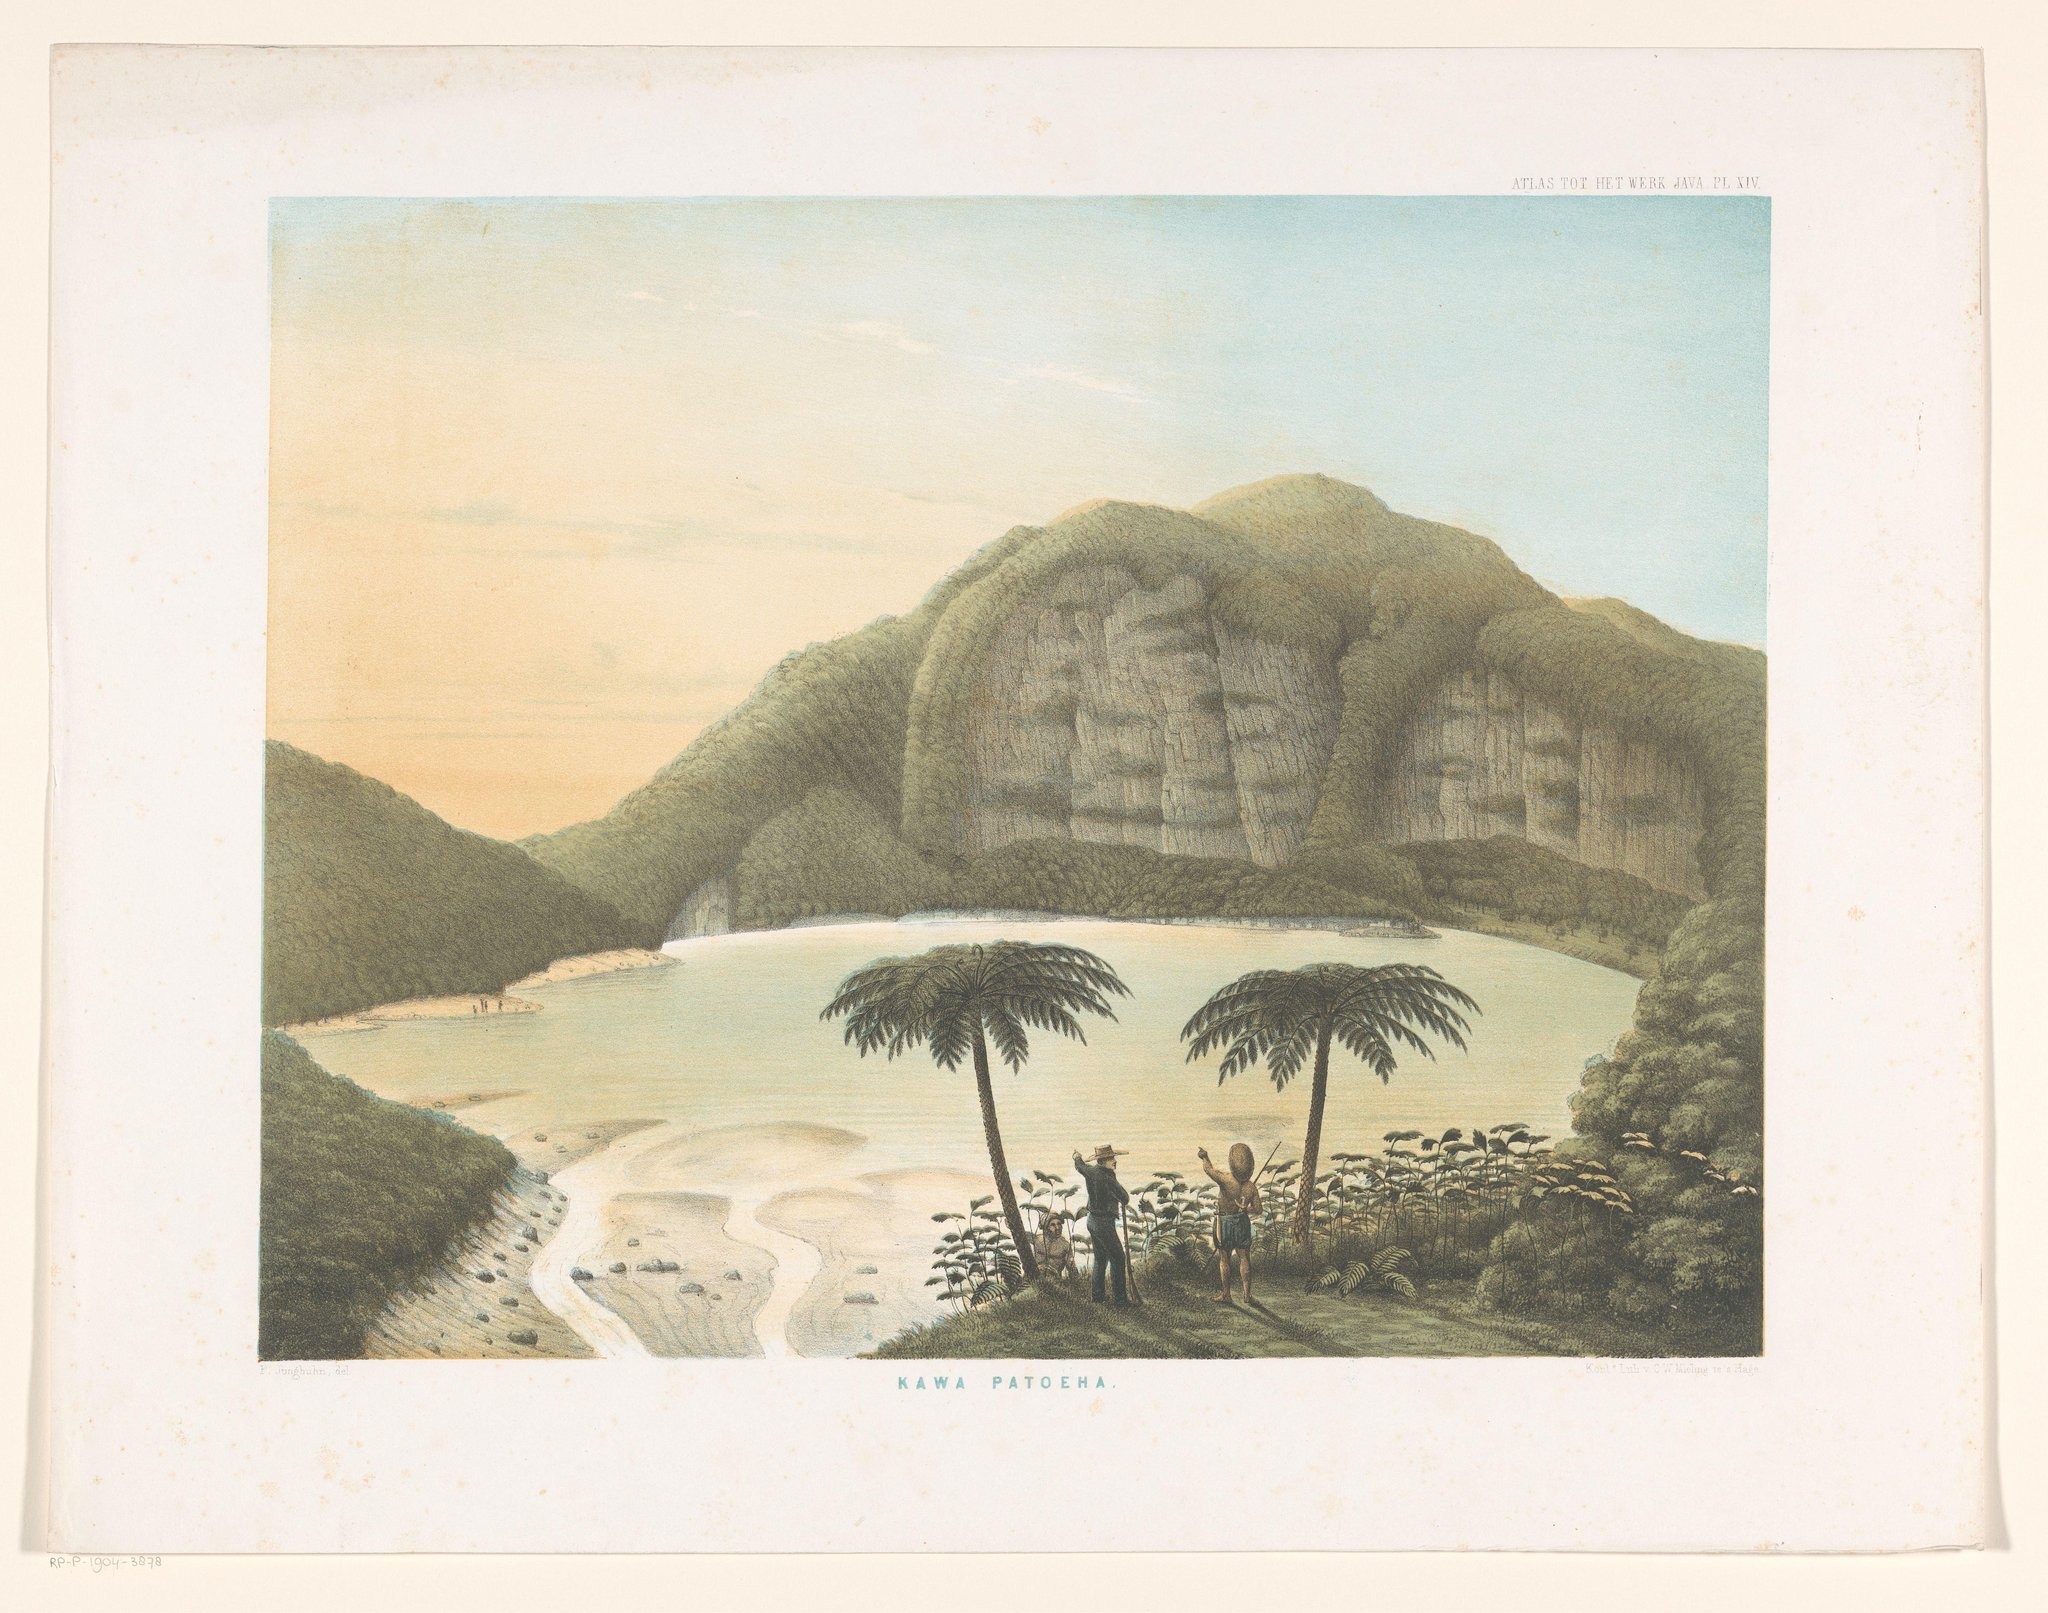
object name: print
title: Kawa Patoeha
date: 1854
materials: paper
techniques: lithograph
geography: the hague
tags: lake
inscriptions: collector's mark: Lugt 2228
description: Onderdeel van een serie van elf. Deze serie is uitgebracht als aanvulling op: Junghuhn, F.W. Java, zijne gedaante, zijn plantentooi en inwendige bouw (I, II, III, IV). Den Haag: Mieling, C.W. 1853-54. Zie ook RP-P-1904-3882 (ander kleurenpalet).